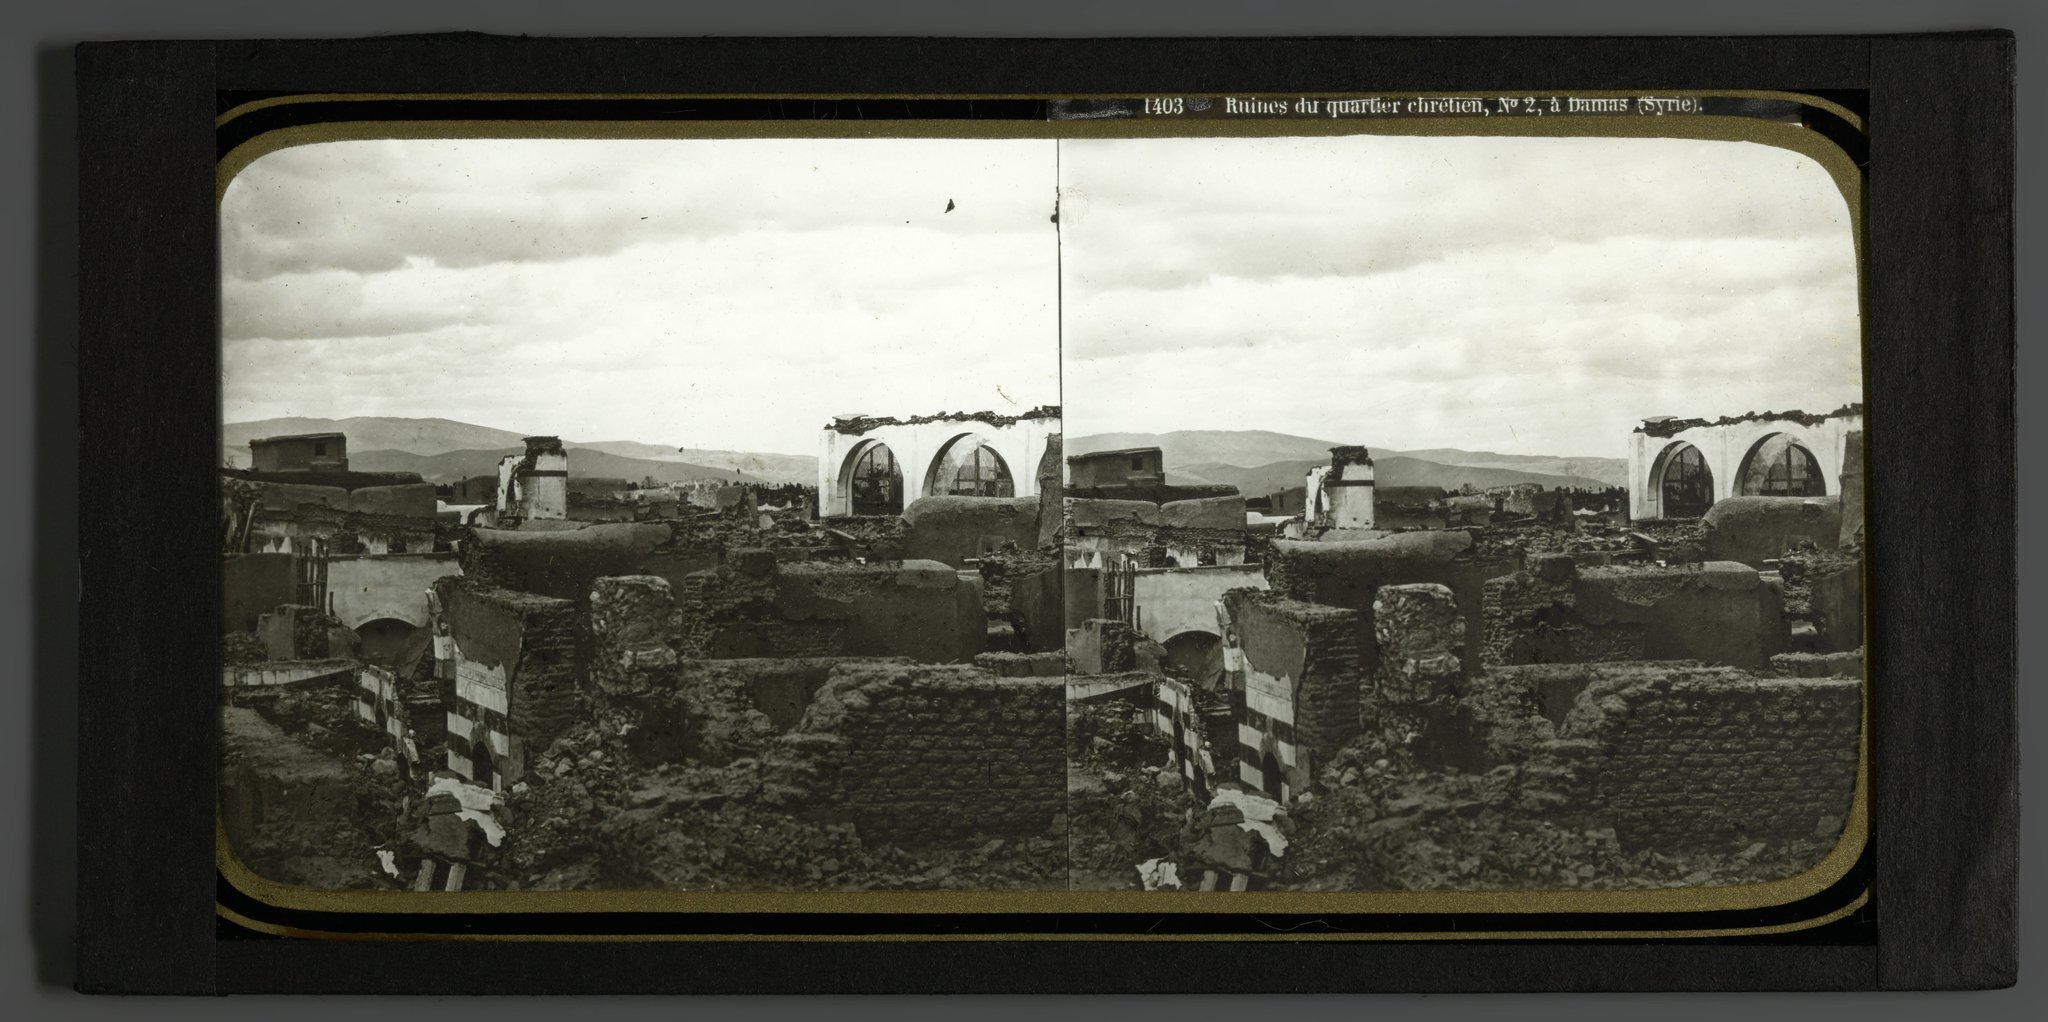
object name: stereoscopic photograph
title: Ruïnes in de christelijke wijk van Damascus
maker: ferrier père-fils et soulier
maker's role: publisher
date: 1860-1880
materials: glass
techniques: slide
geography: damascus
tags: ruin of a dwelling, house, castle, etc.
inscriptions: number: ‘1403’